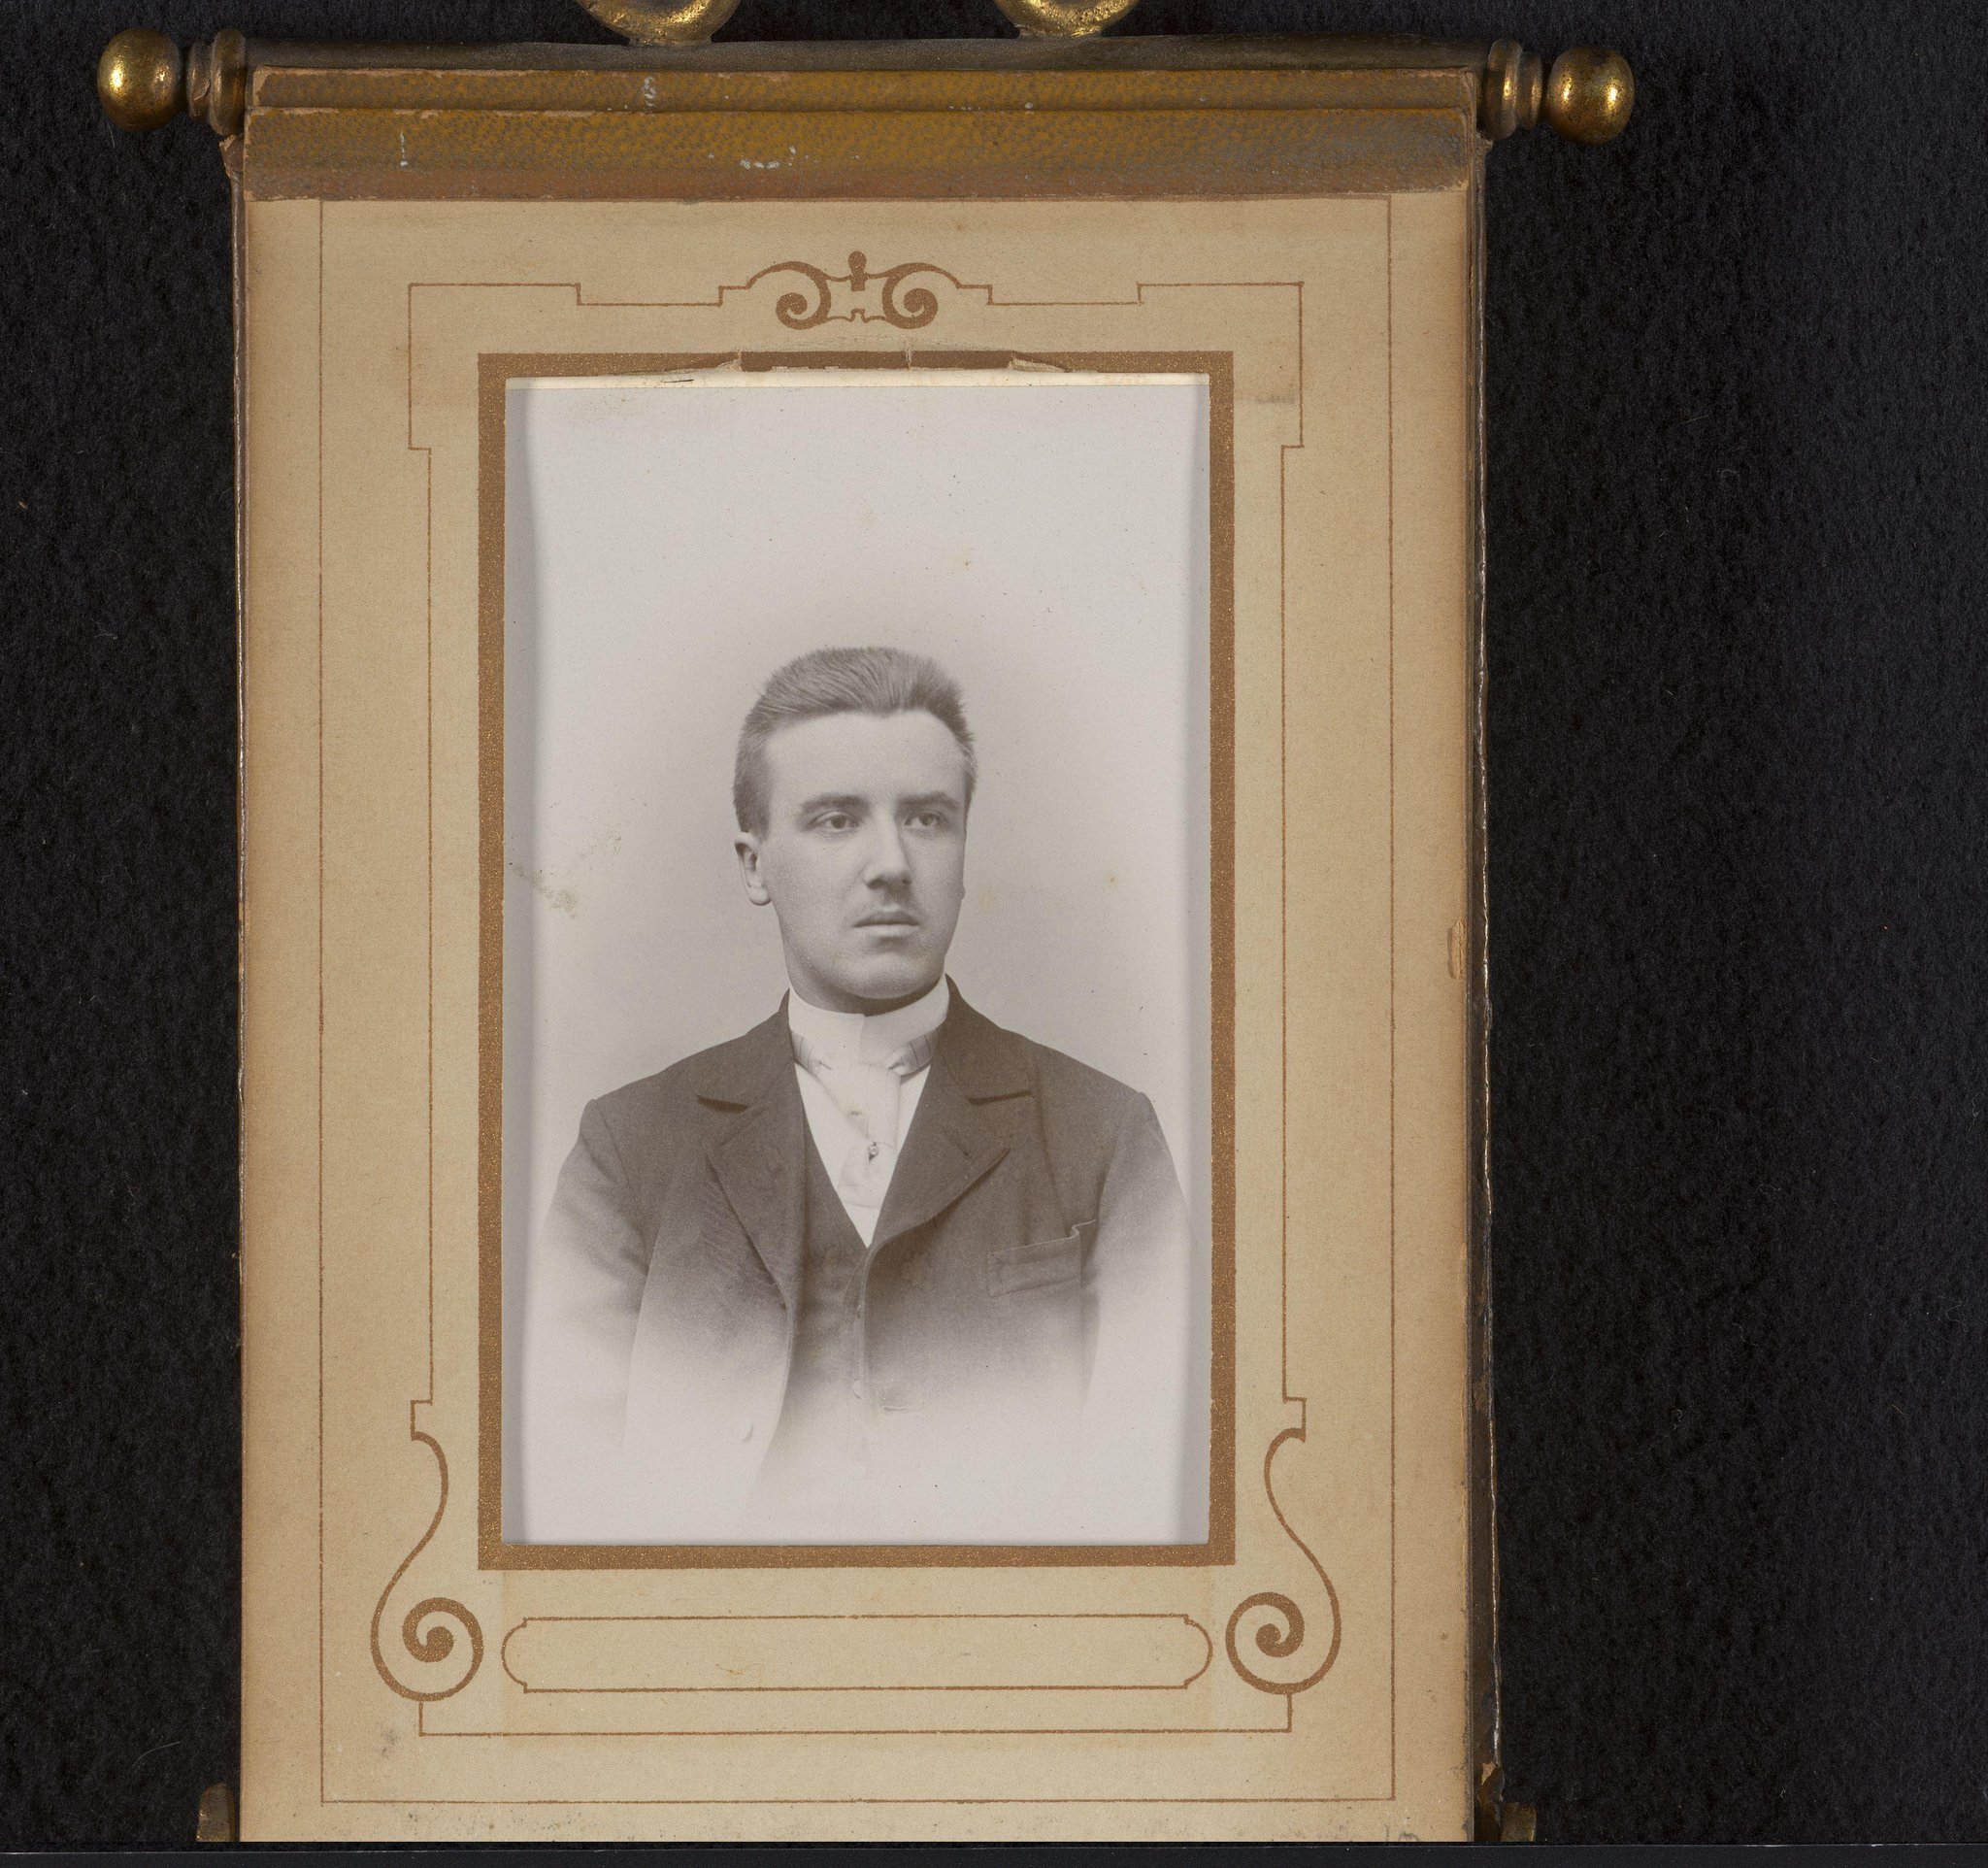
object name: carte de visite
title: Portret van een jonge man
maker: otto damm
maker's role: fotograaf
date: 1898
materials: cardboard, photographic support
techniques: collodion silver print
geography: marburg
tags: historical persons, youth, adolescent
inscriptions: inscription: ‘Otto Damm/ Photograph/ Marburg i/H./ Augustinergasse/ gegenüber dem neuen Gymnasium.’, annotation: ‘[...] Dr. Kohlmann/ z. [...] Erg./ W. 18.09.89 S.’